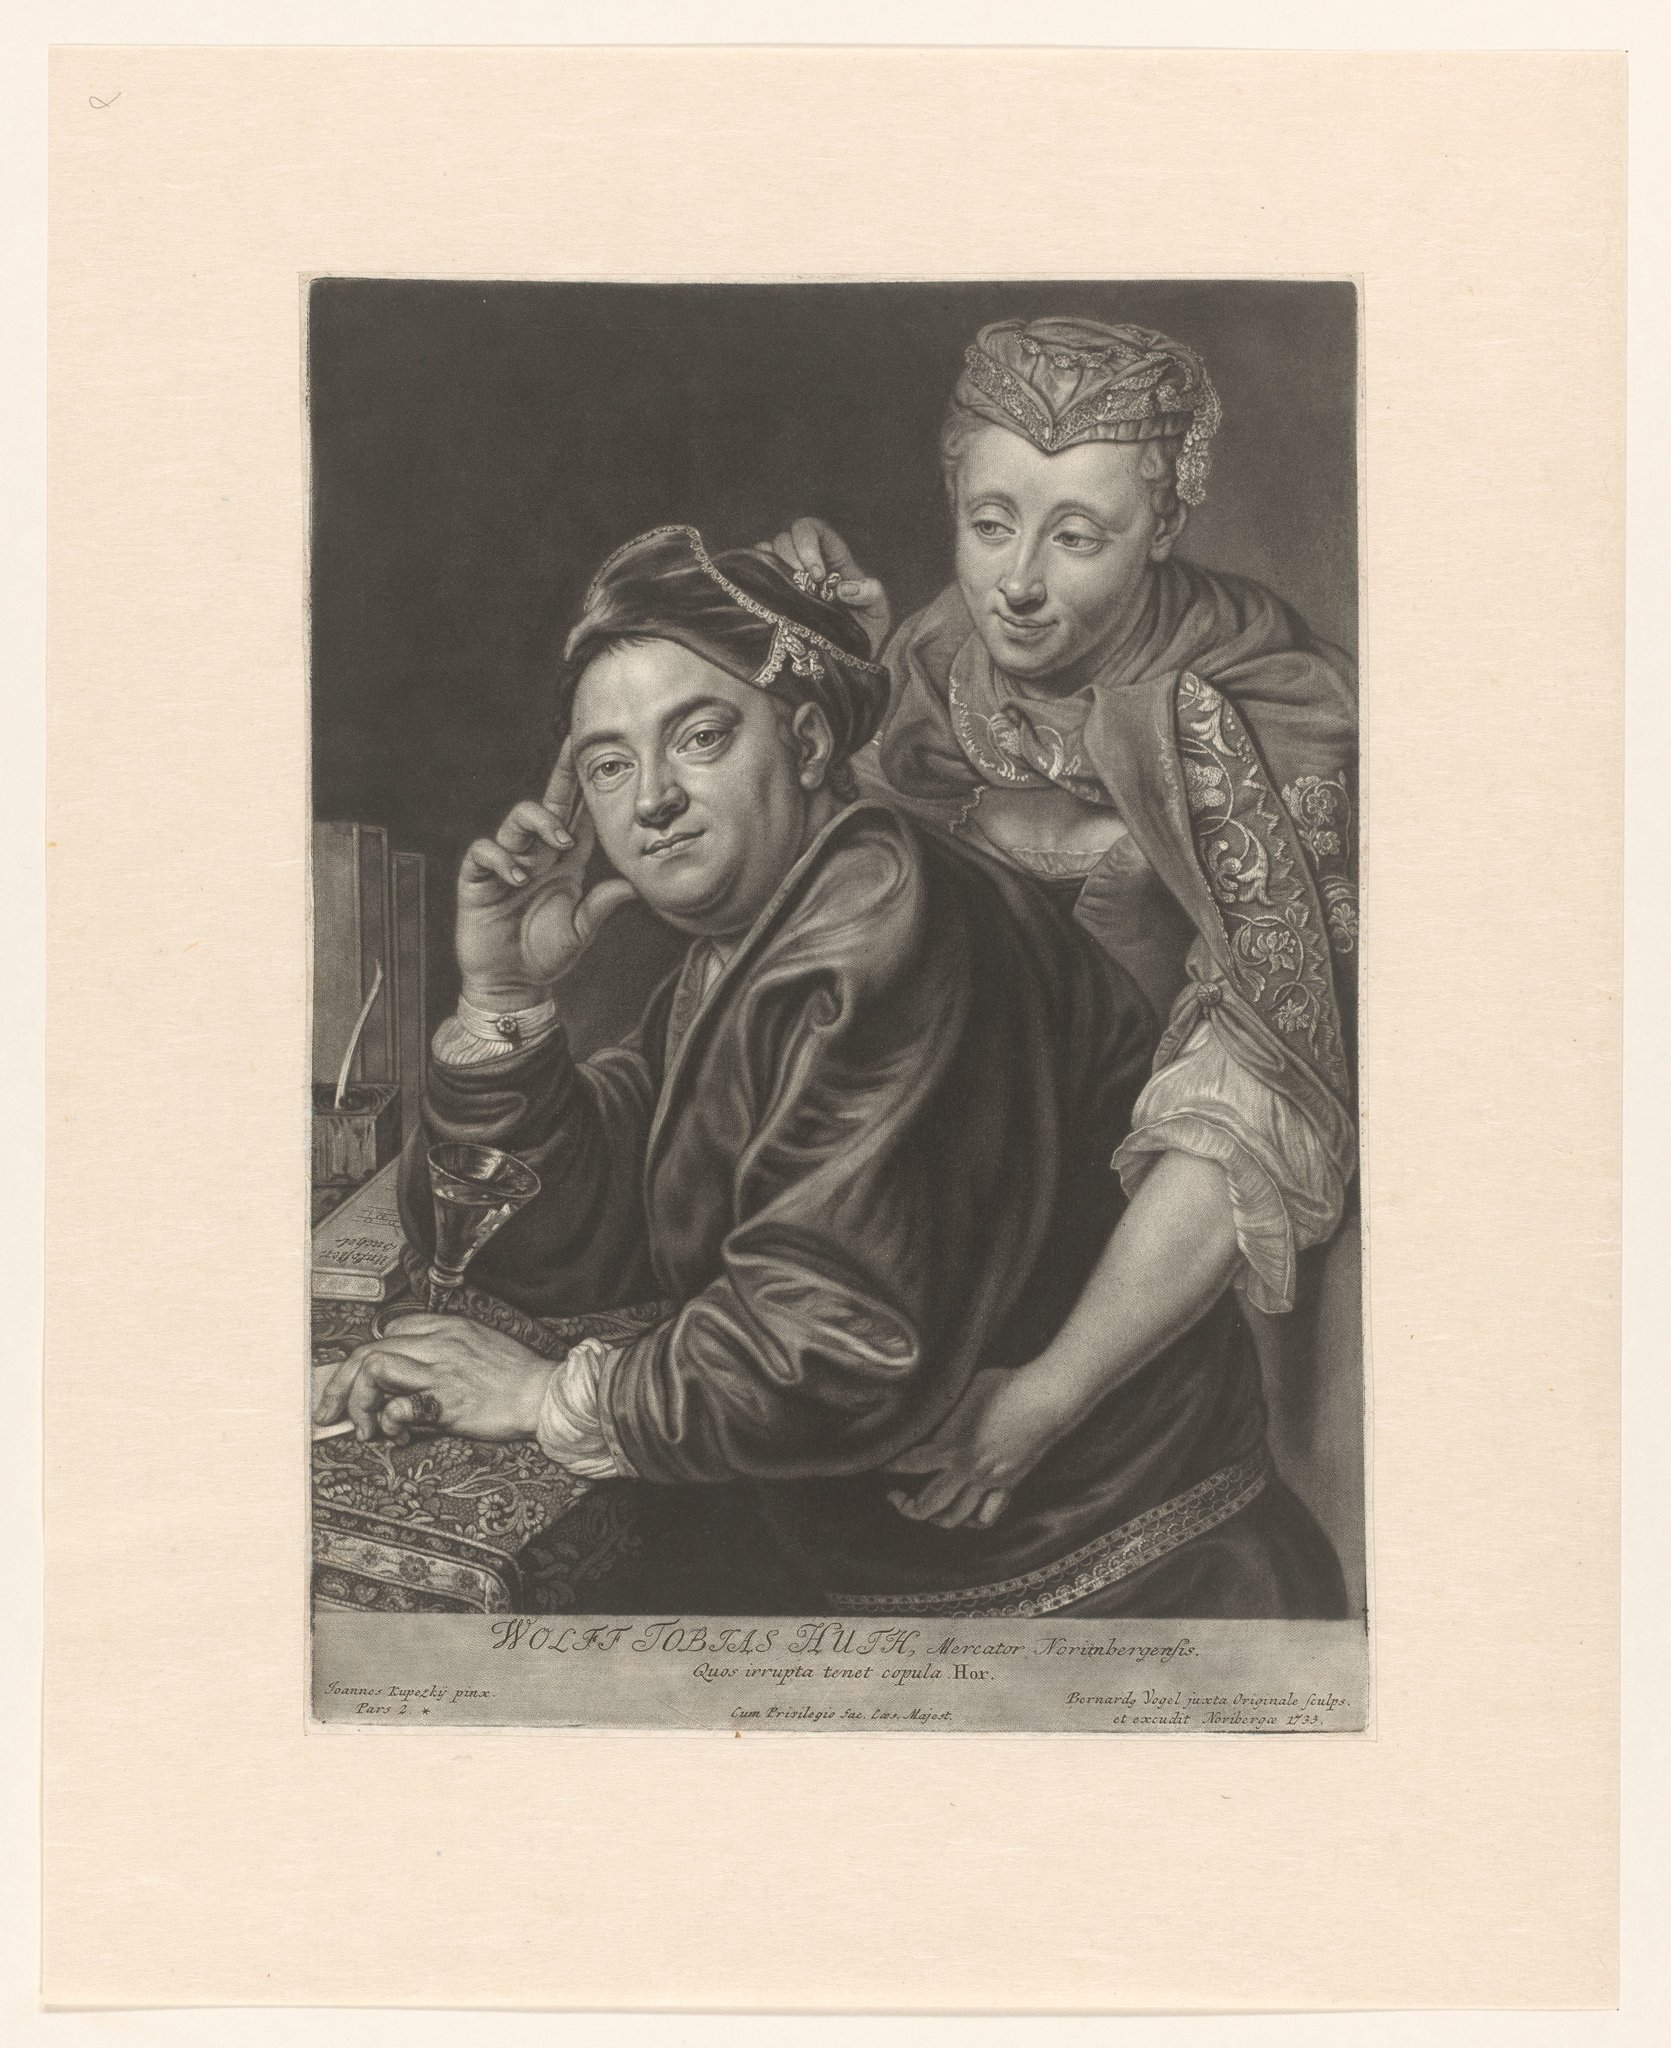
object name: print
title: Dubbelportret van Wolf Tobias Huth en zijn vrouw Susanna Johanna Huth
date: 1735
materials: paper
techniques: mezzotint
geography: paris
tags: historical persons - bb - woman, historical person - woman - in a double portrait, historical persons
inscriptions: collector's mark: Lugt 2228, collector's mark: Lugt 2760